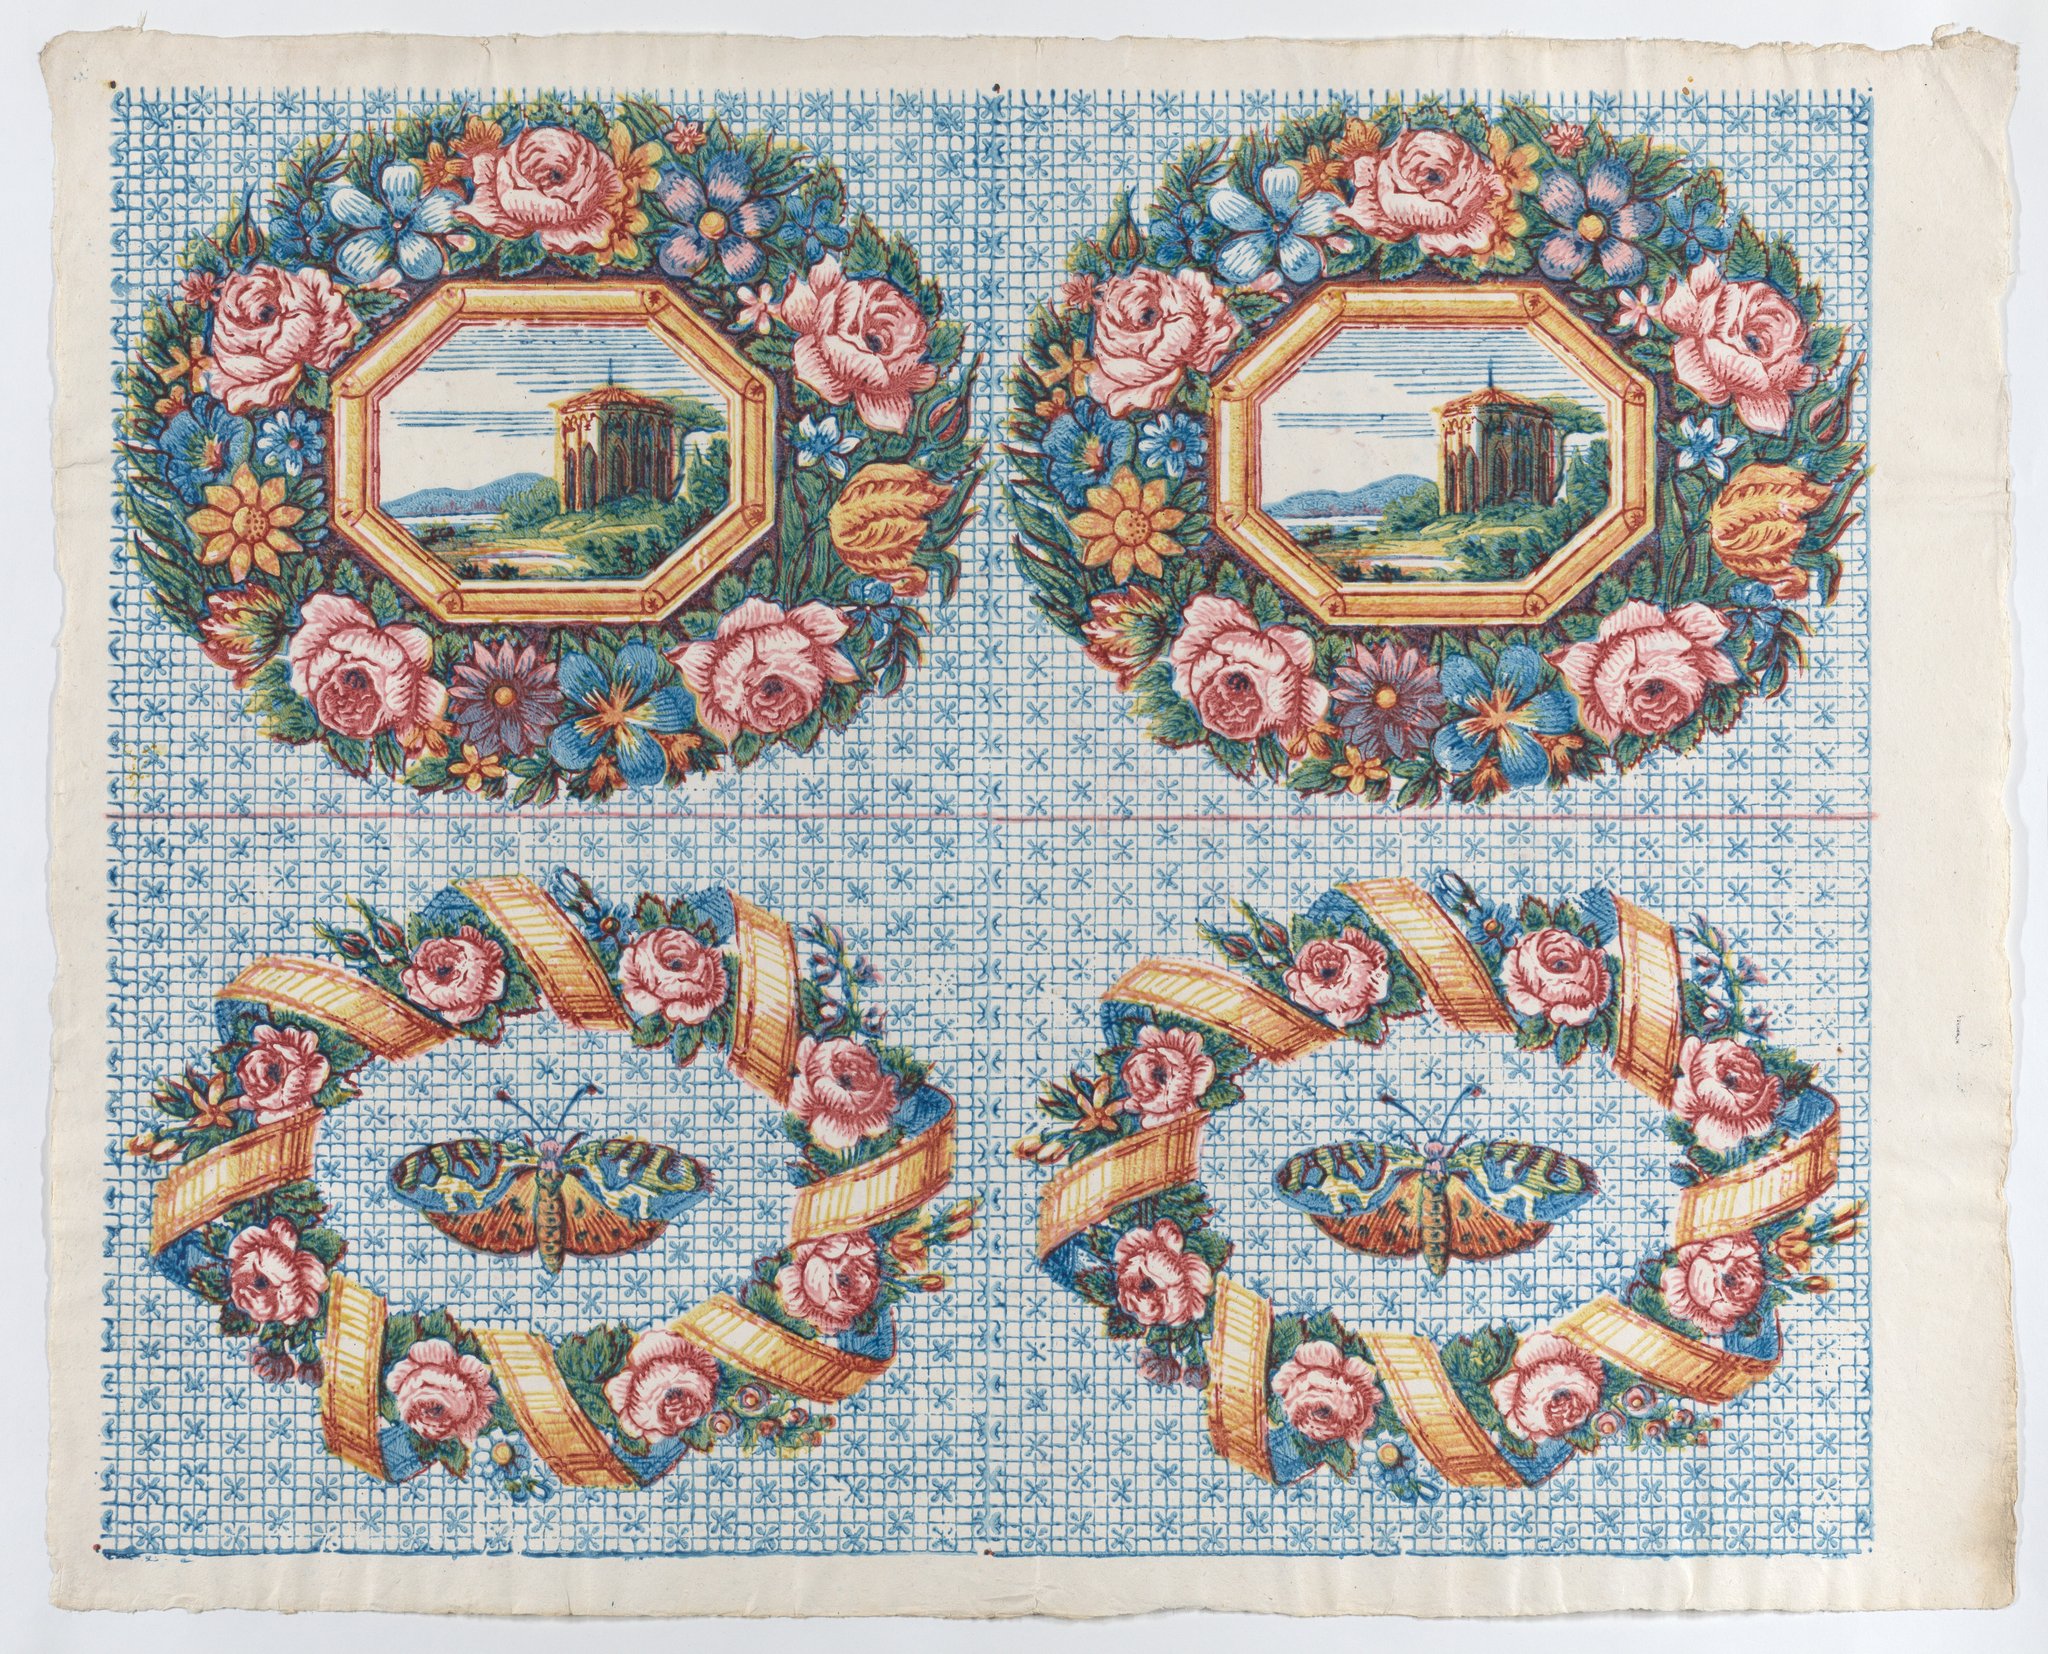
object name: print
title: Sheet with two borders with a landscape and moth within wreaths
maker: Anonymous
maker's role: artist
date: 1767-1866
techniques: relief print